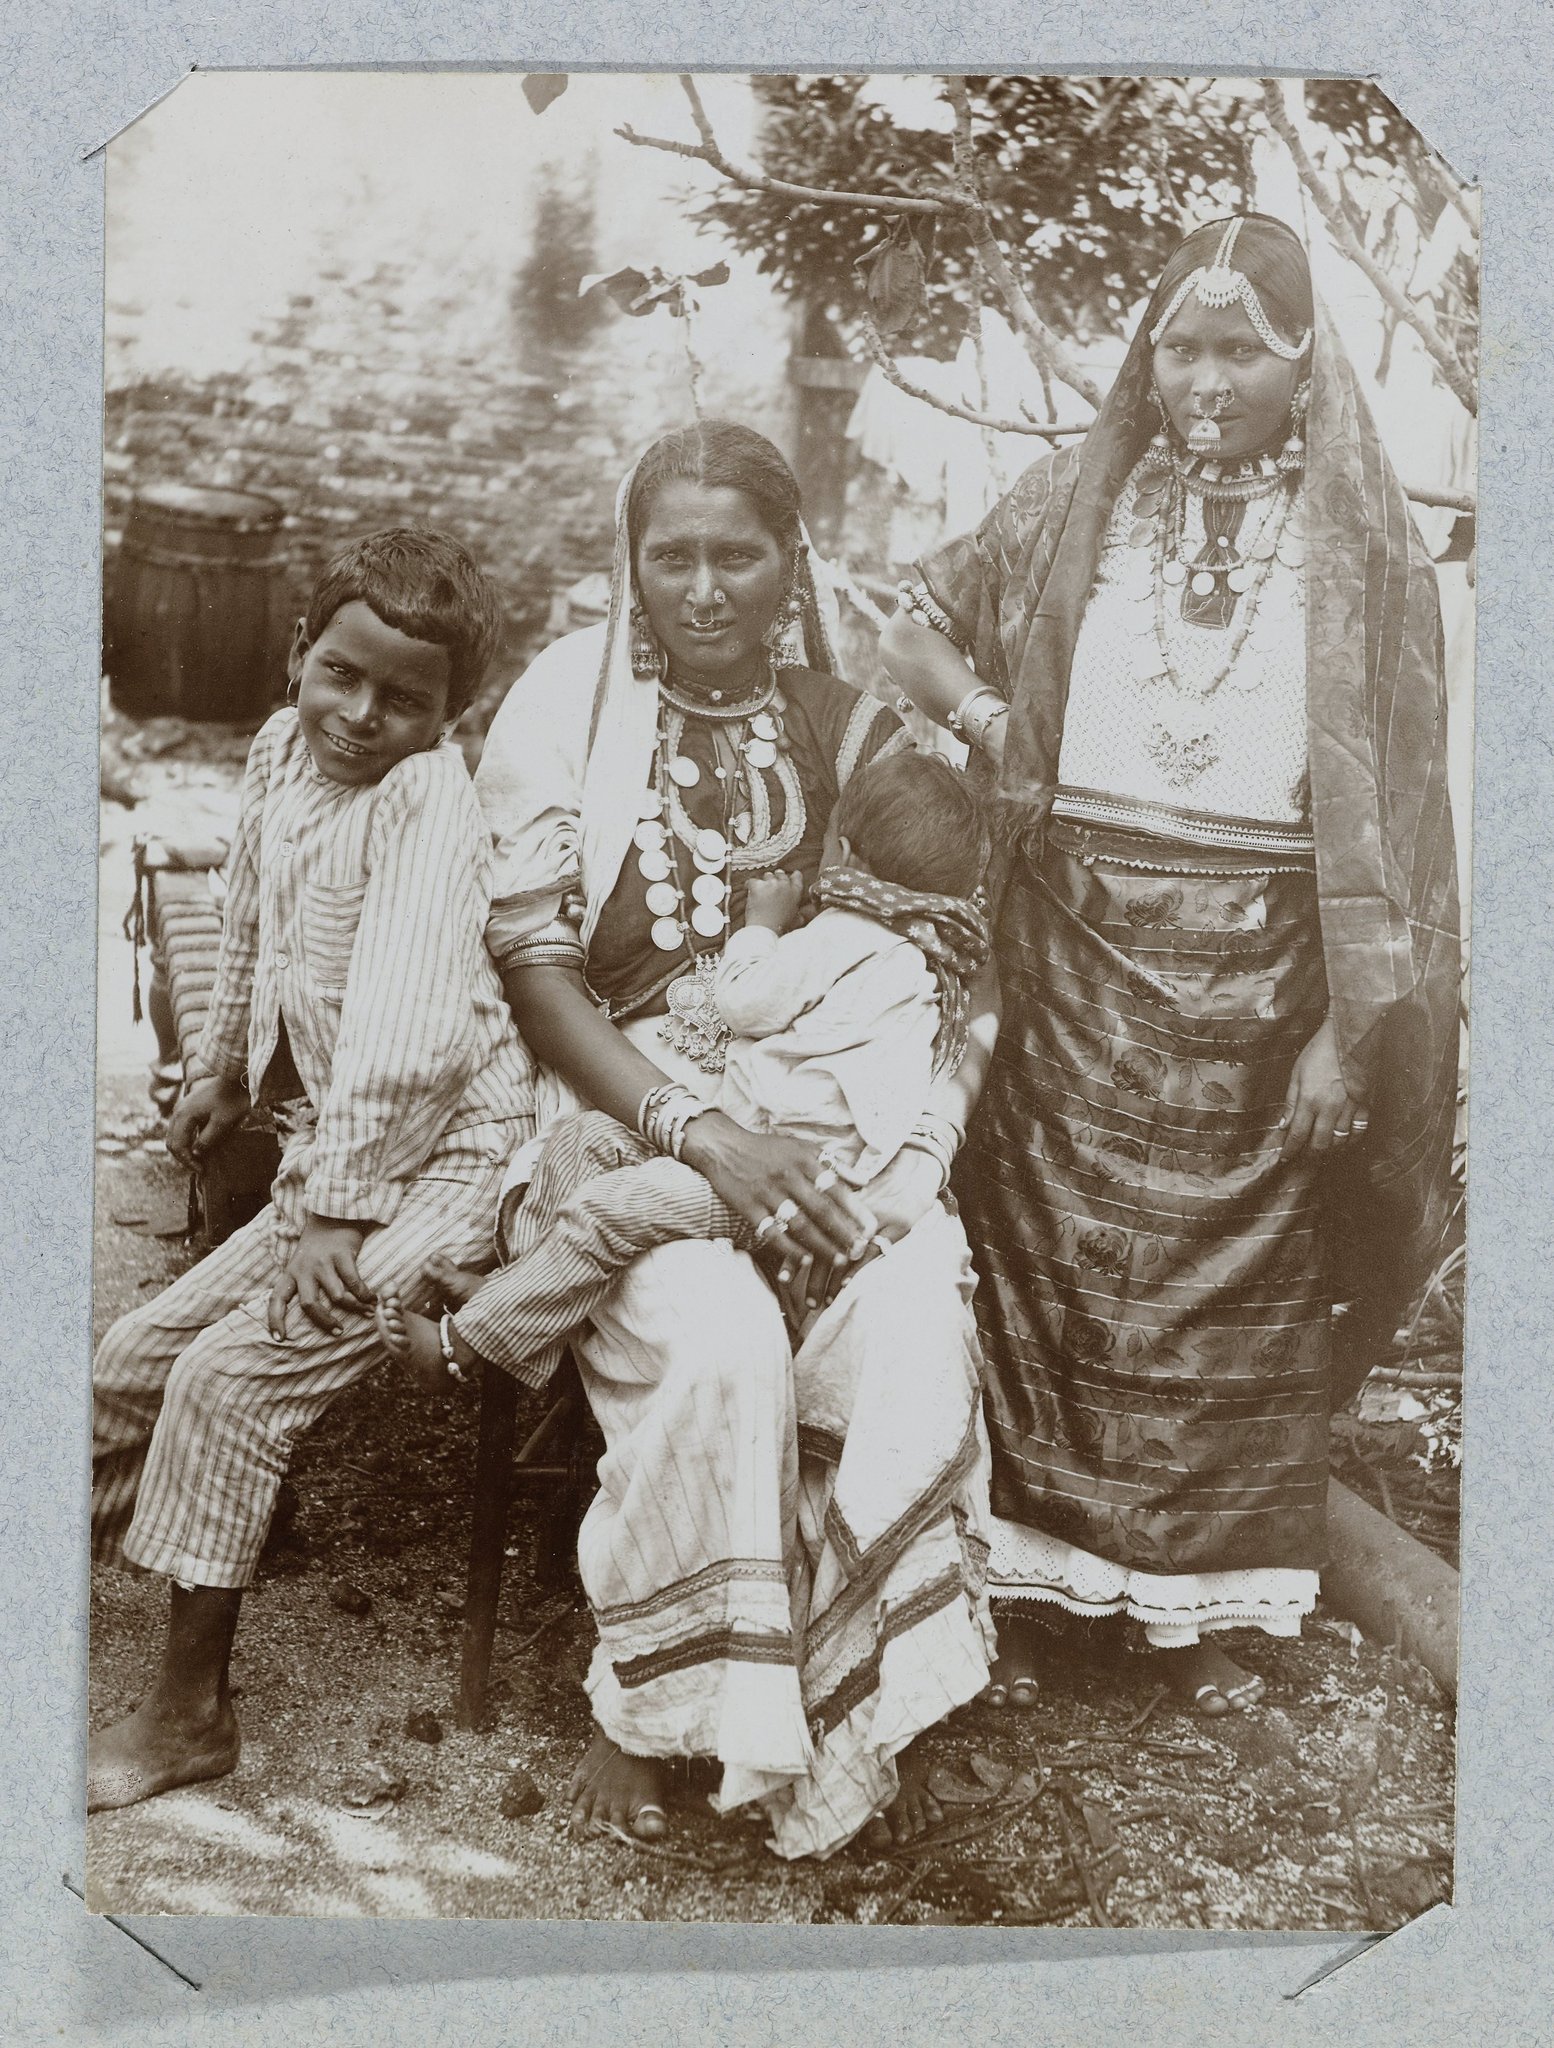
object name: photograph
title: Hindustani Women with Children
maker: théodore van lelyveld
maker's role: painter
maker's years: 1867-1954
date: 1895-1898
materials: photographic support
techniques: collodion silver print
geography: suriname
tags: migrants, working class, labourers, anonymous historical person portrayed - bb - woman, suriname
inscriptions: inscription: ‘Plaat 38 (opname van den schrijver)’, inscription: ‘Br. Ind. Koelievrouwen en kinderen.’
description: Van Lelyveld takes these photographs for his article on the clothing of Hindustani women. Both women wear a mohar málá, a necklace made of coins. The children also wear jewellery. The jewels represent the women’s capital and afford insight into their position within the Hindustani community. In Suriname many women transcend the caste they originally had in India.